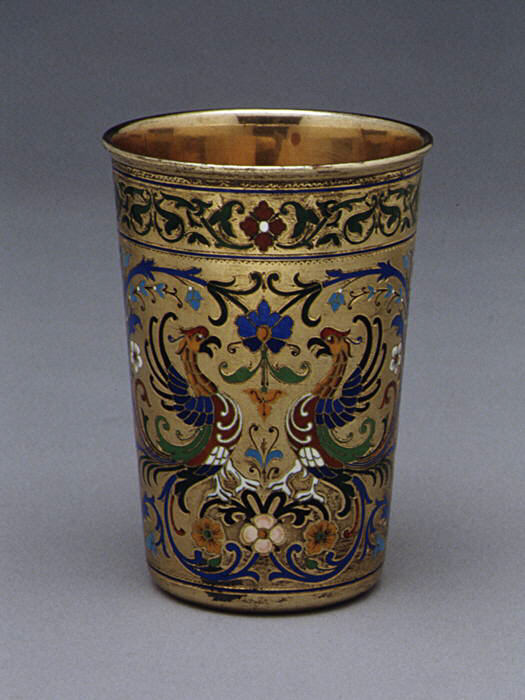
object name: beaker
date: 1876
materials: enamel, silver gilt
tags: birds